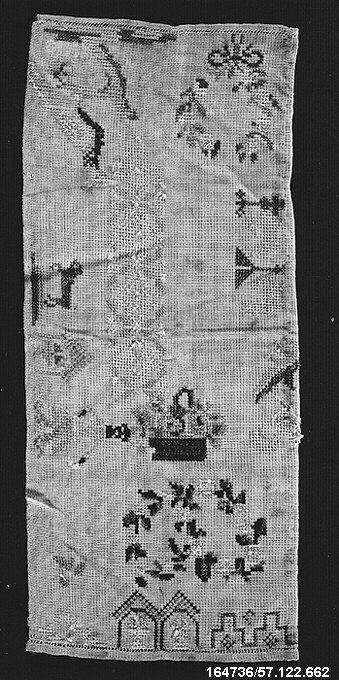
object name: sampler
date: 1801-1900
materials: canvas, silk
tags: animals